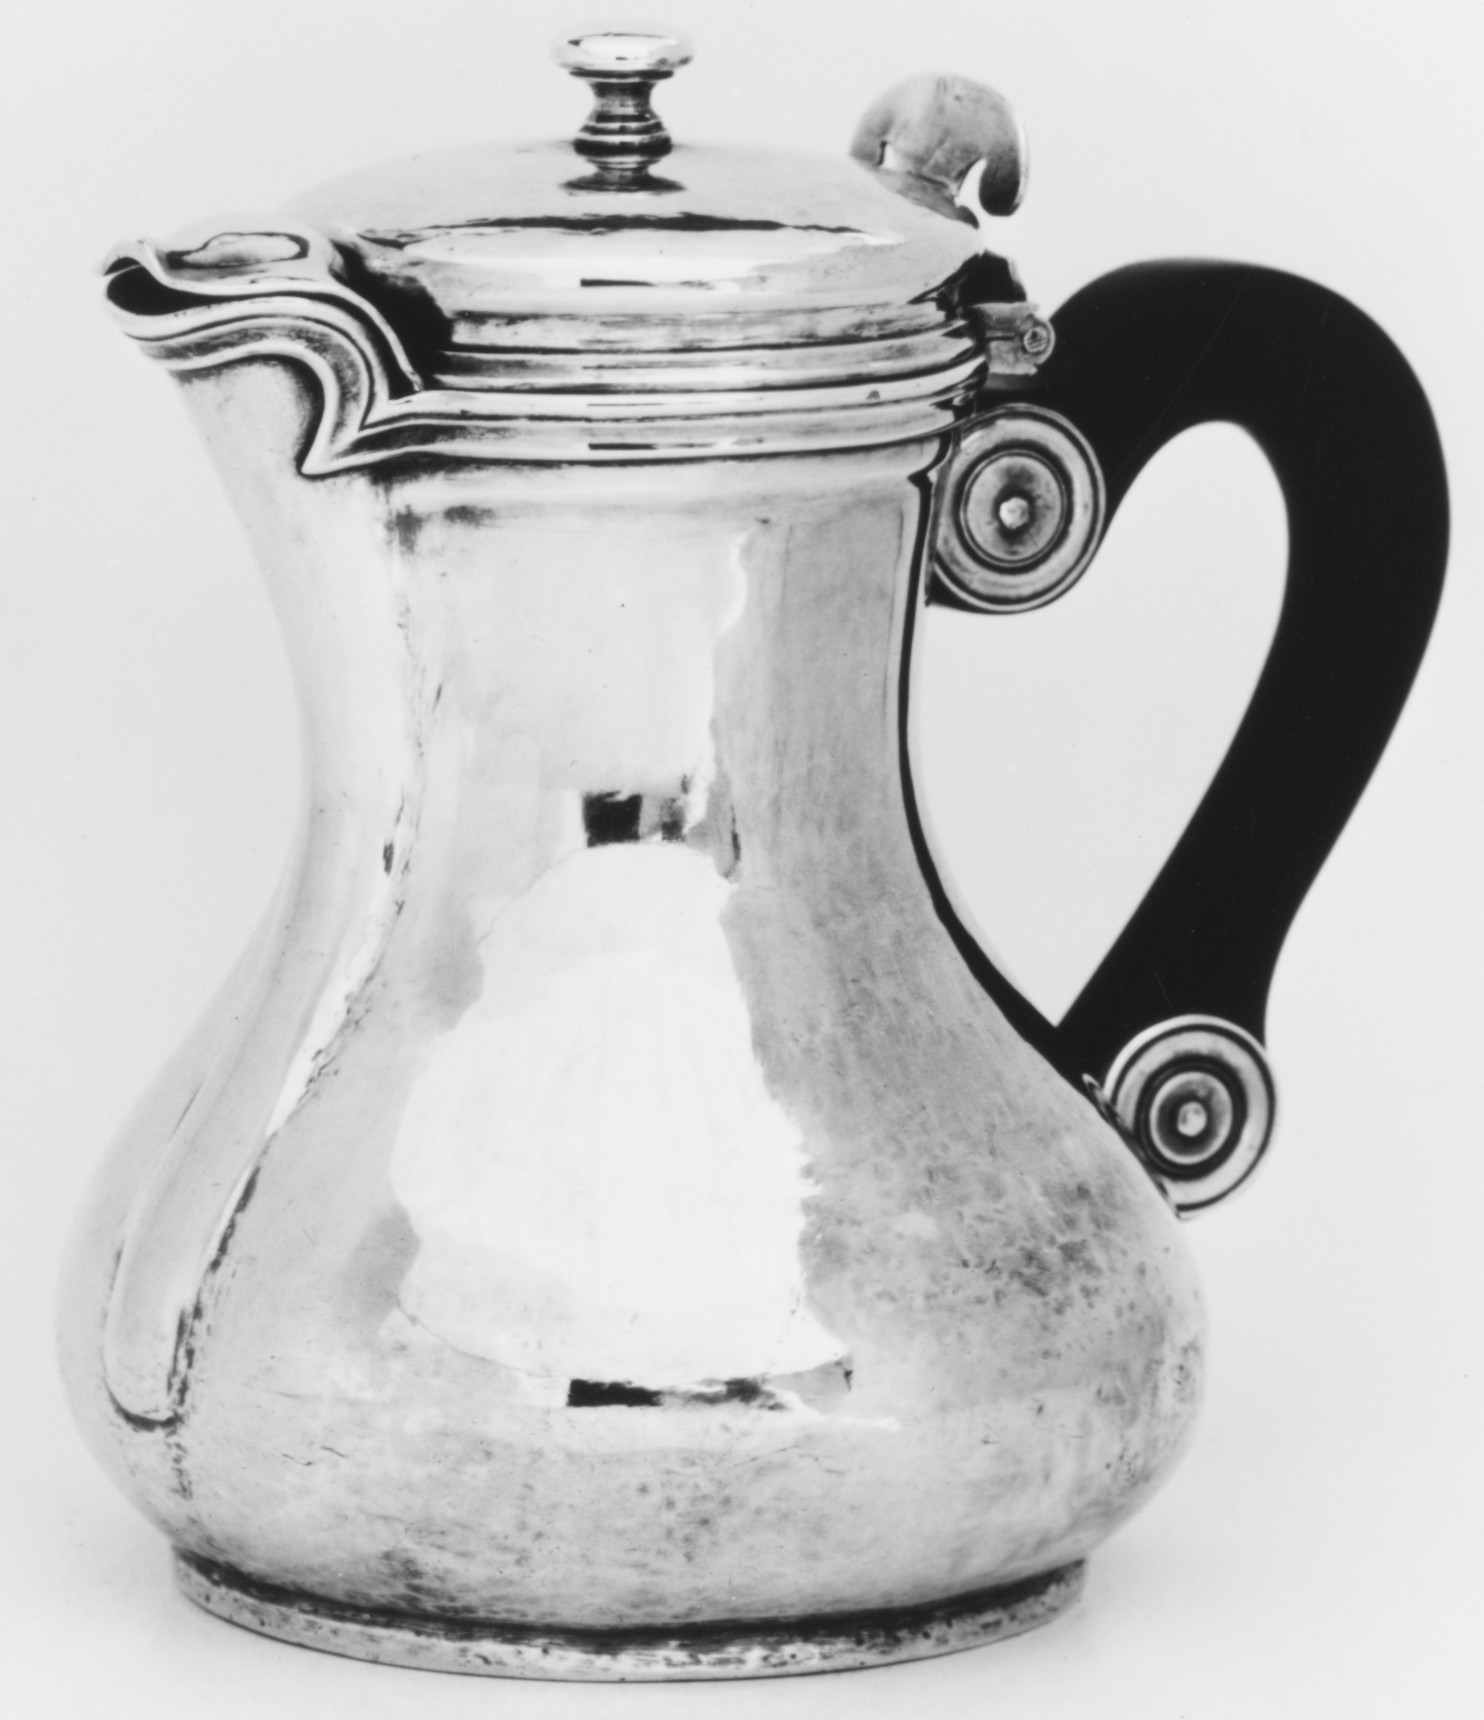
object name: coffeepot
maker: denys frankson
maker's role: maker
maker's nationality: french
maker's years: 1735-1821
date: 1766-1767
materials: wood, silver